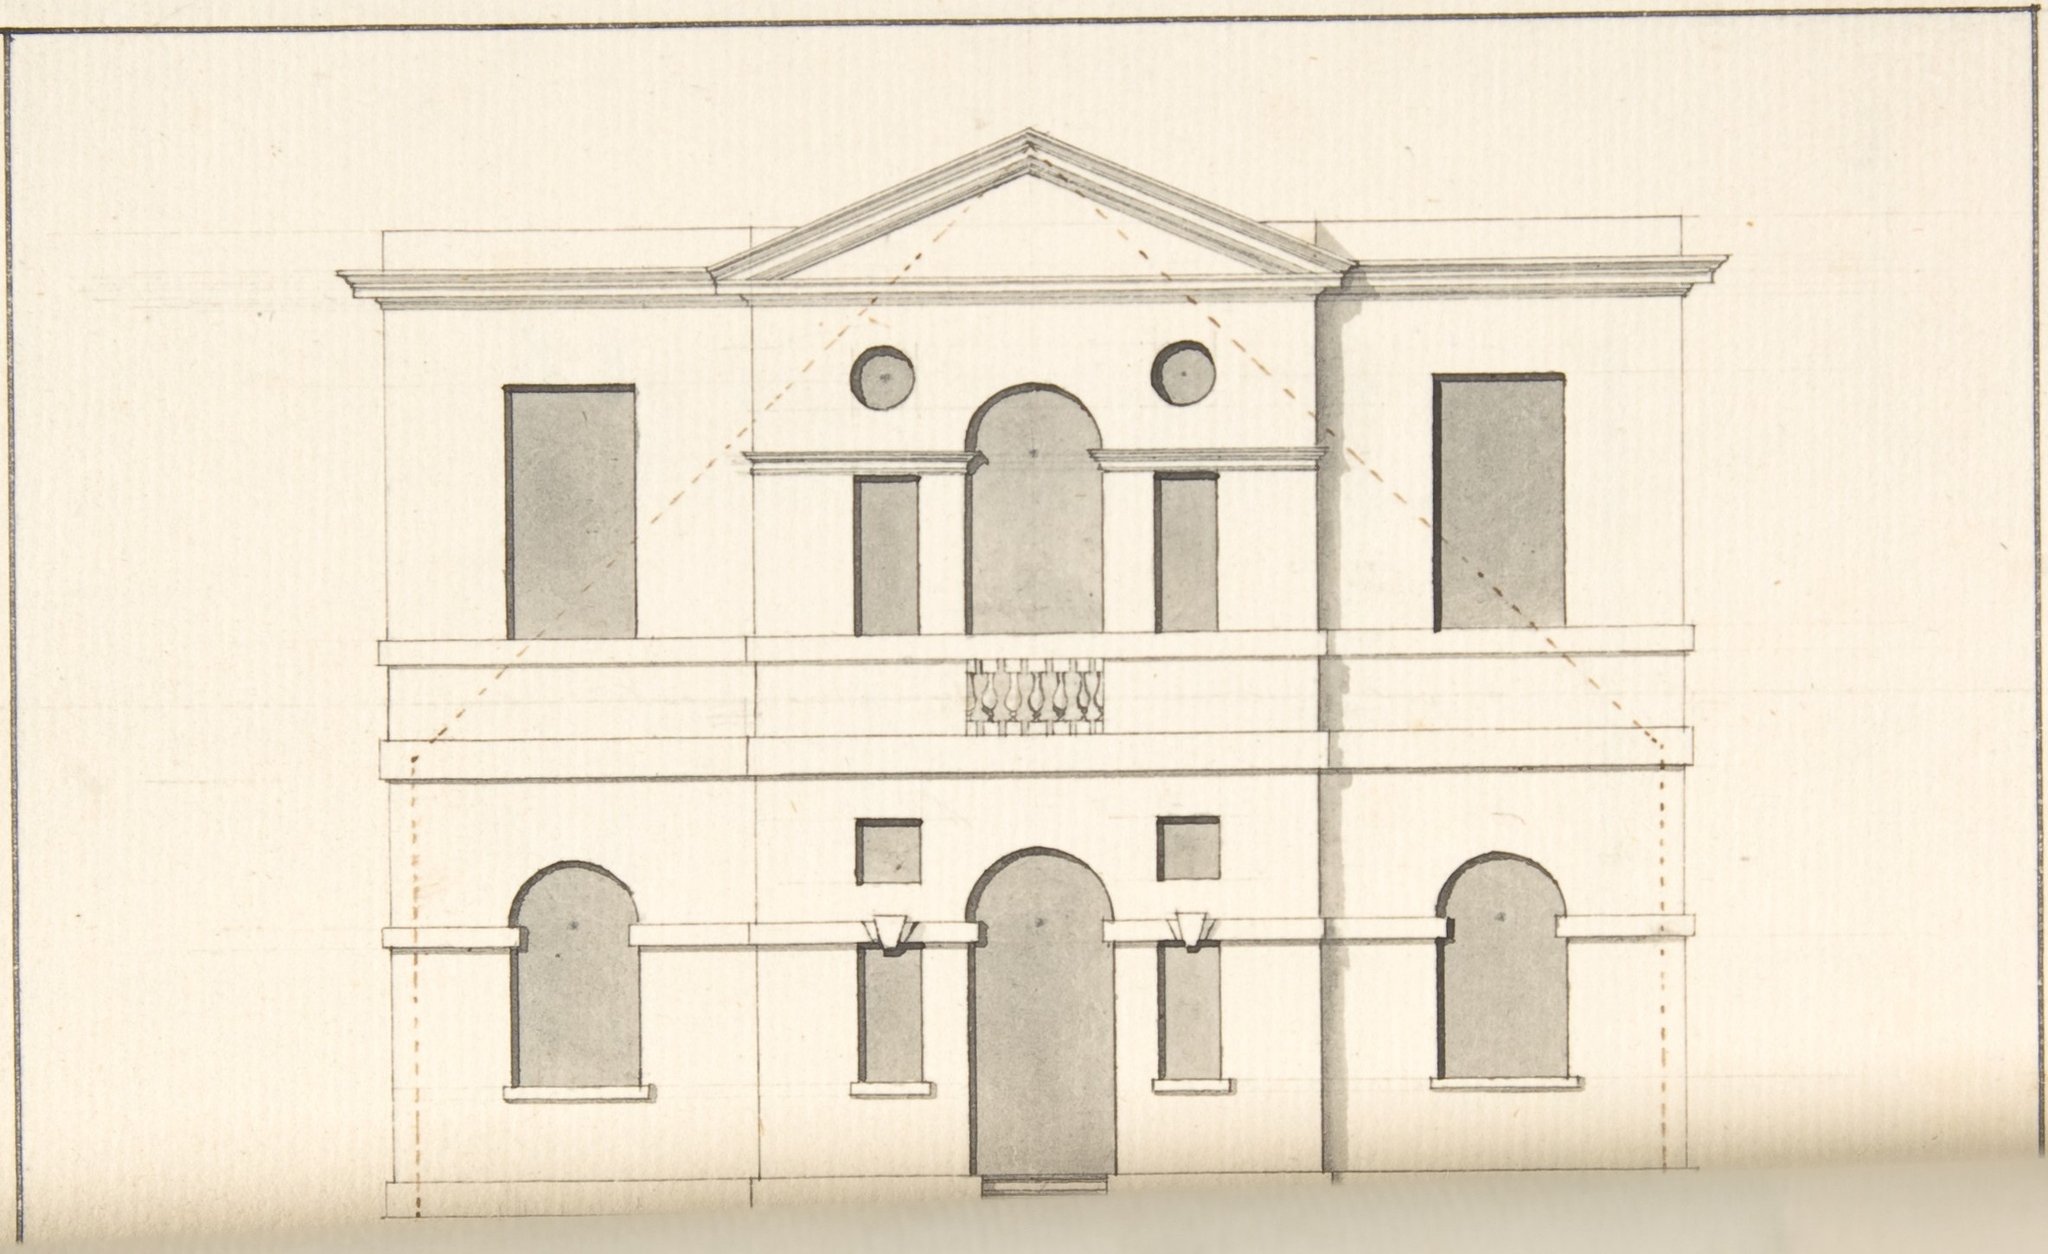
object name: drawing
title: Elevation of "An Eye-trap"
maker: robert morris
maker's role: artist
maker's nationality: british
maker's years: 1701-1754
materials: ink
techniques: brush, pen, wash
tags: architecture